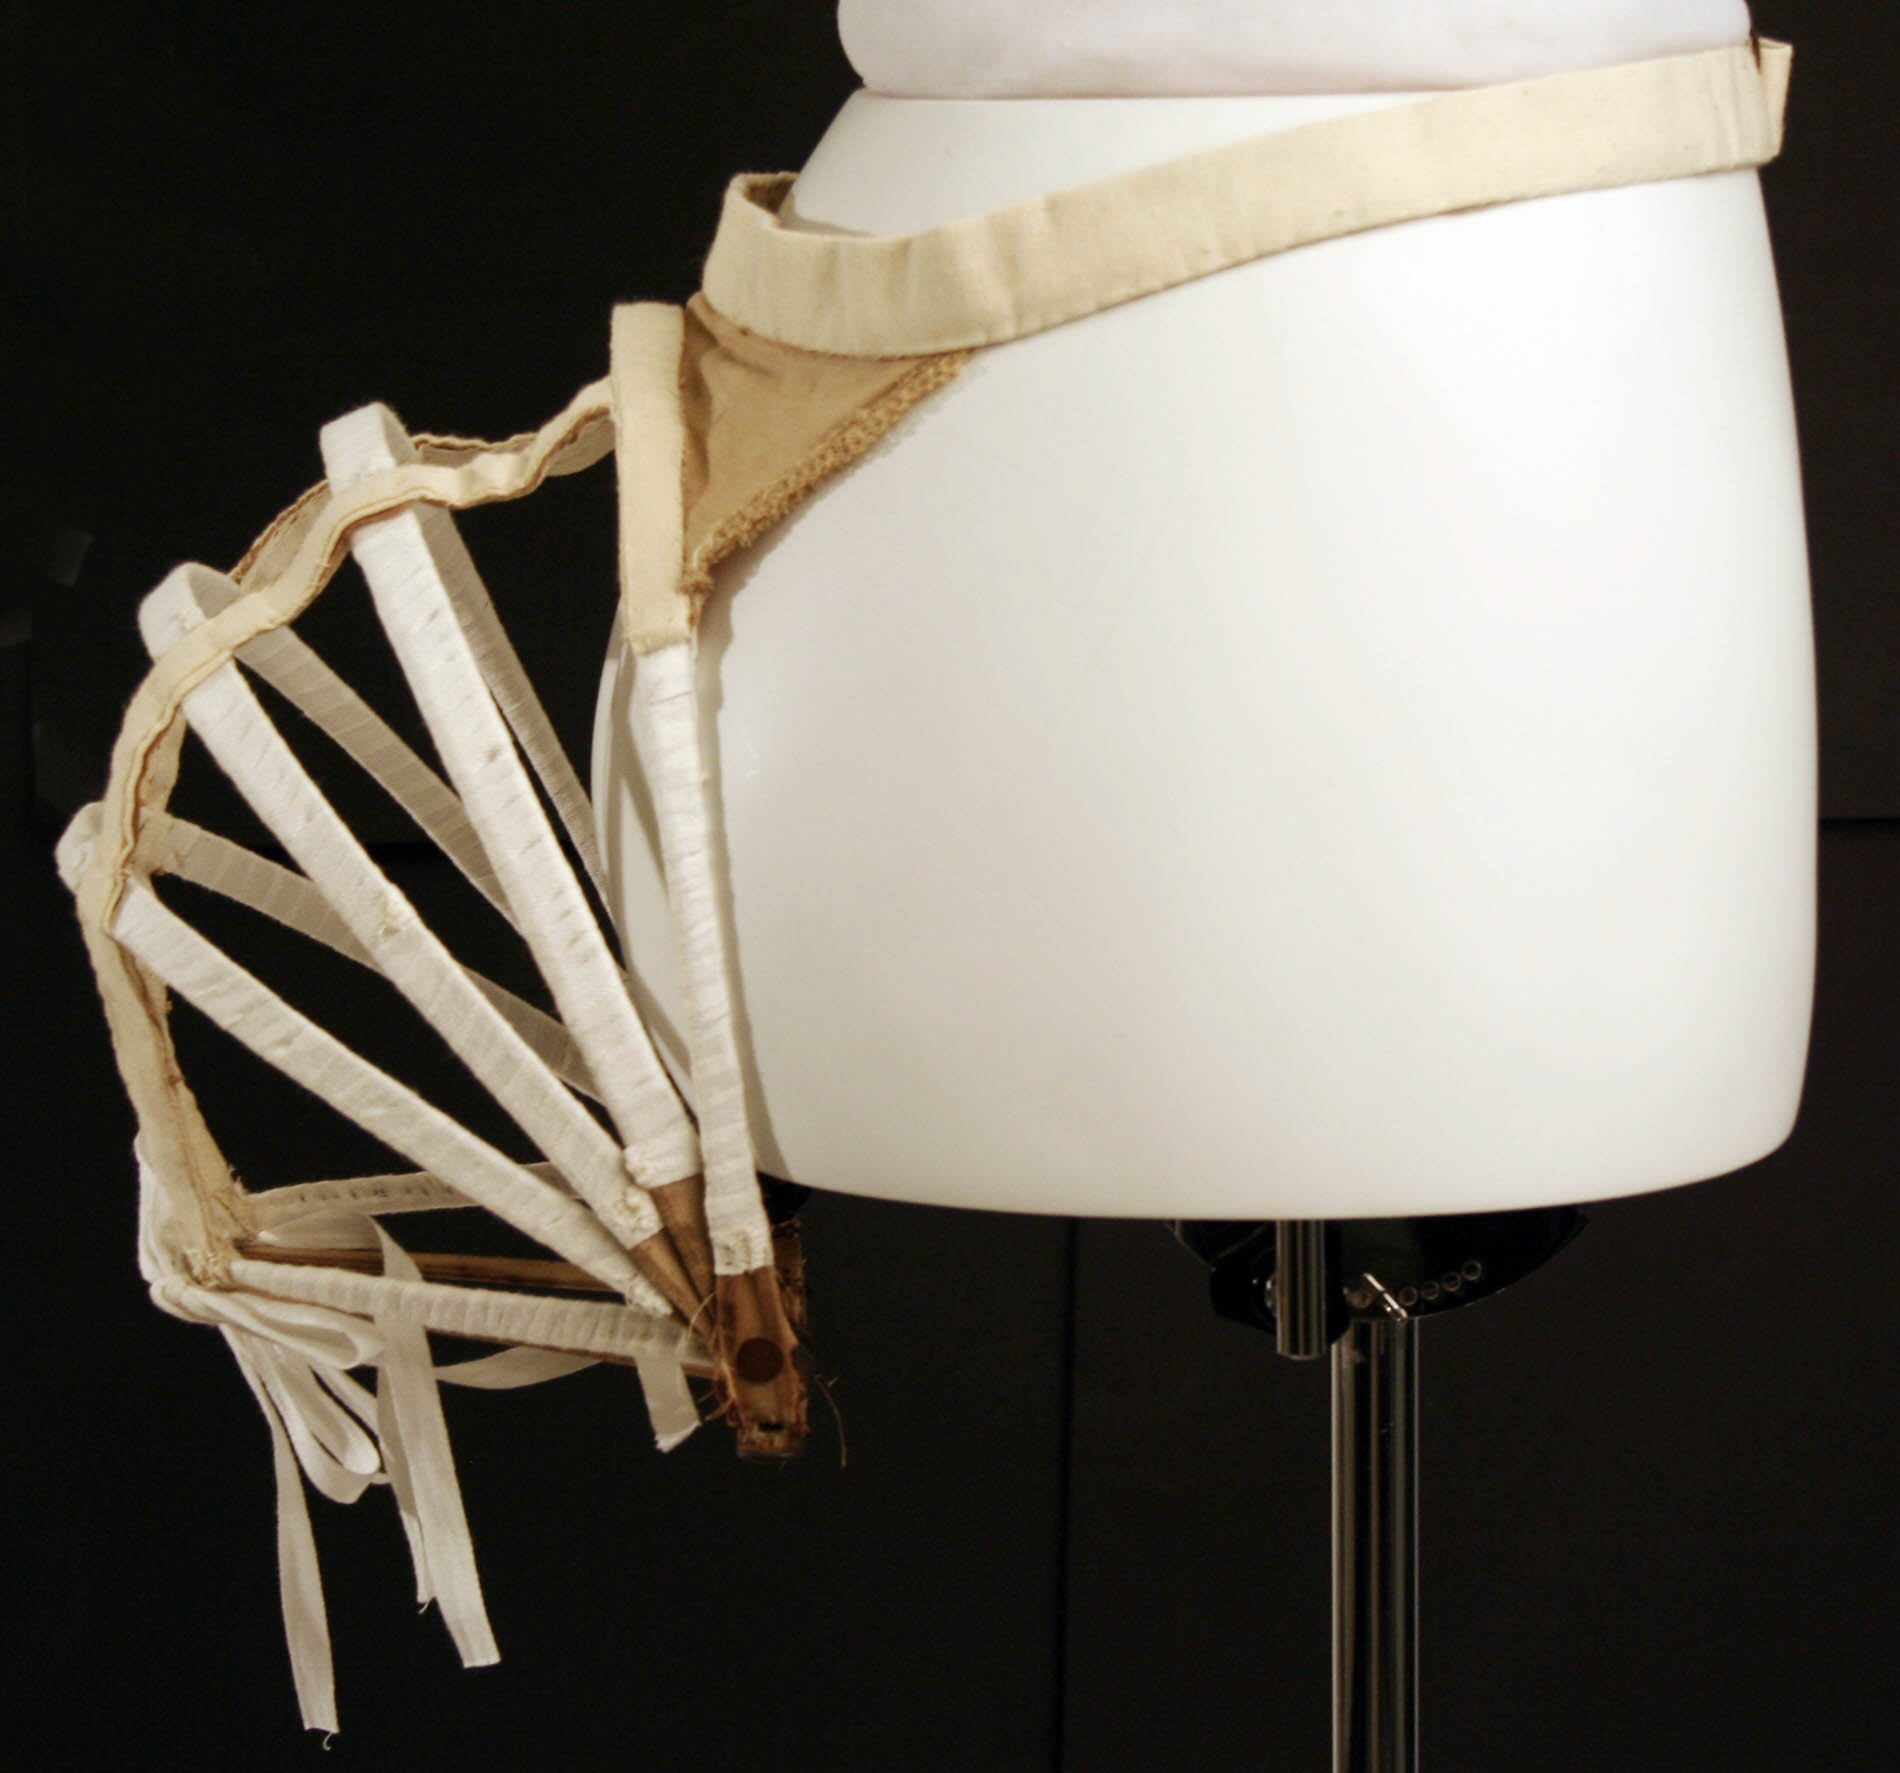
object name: bustle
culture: american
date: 1882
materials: cotton, steel